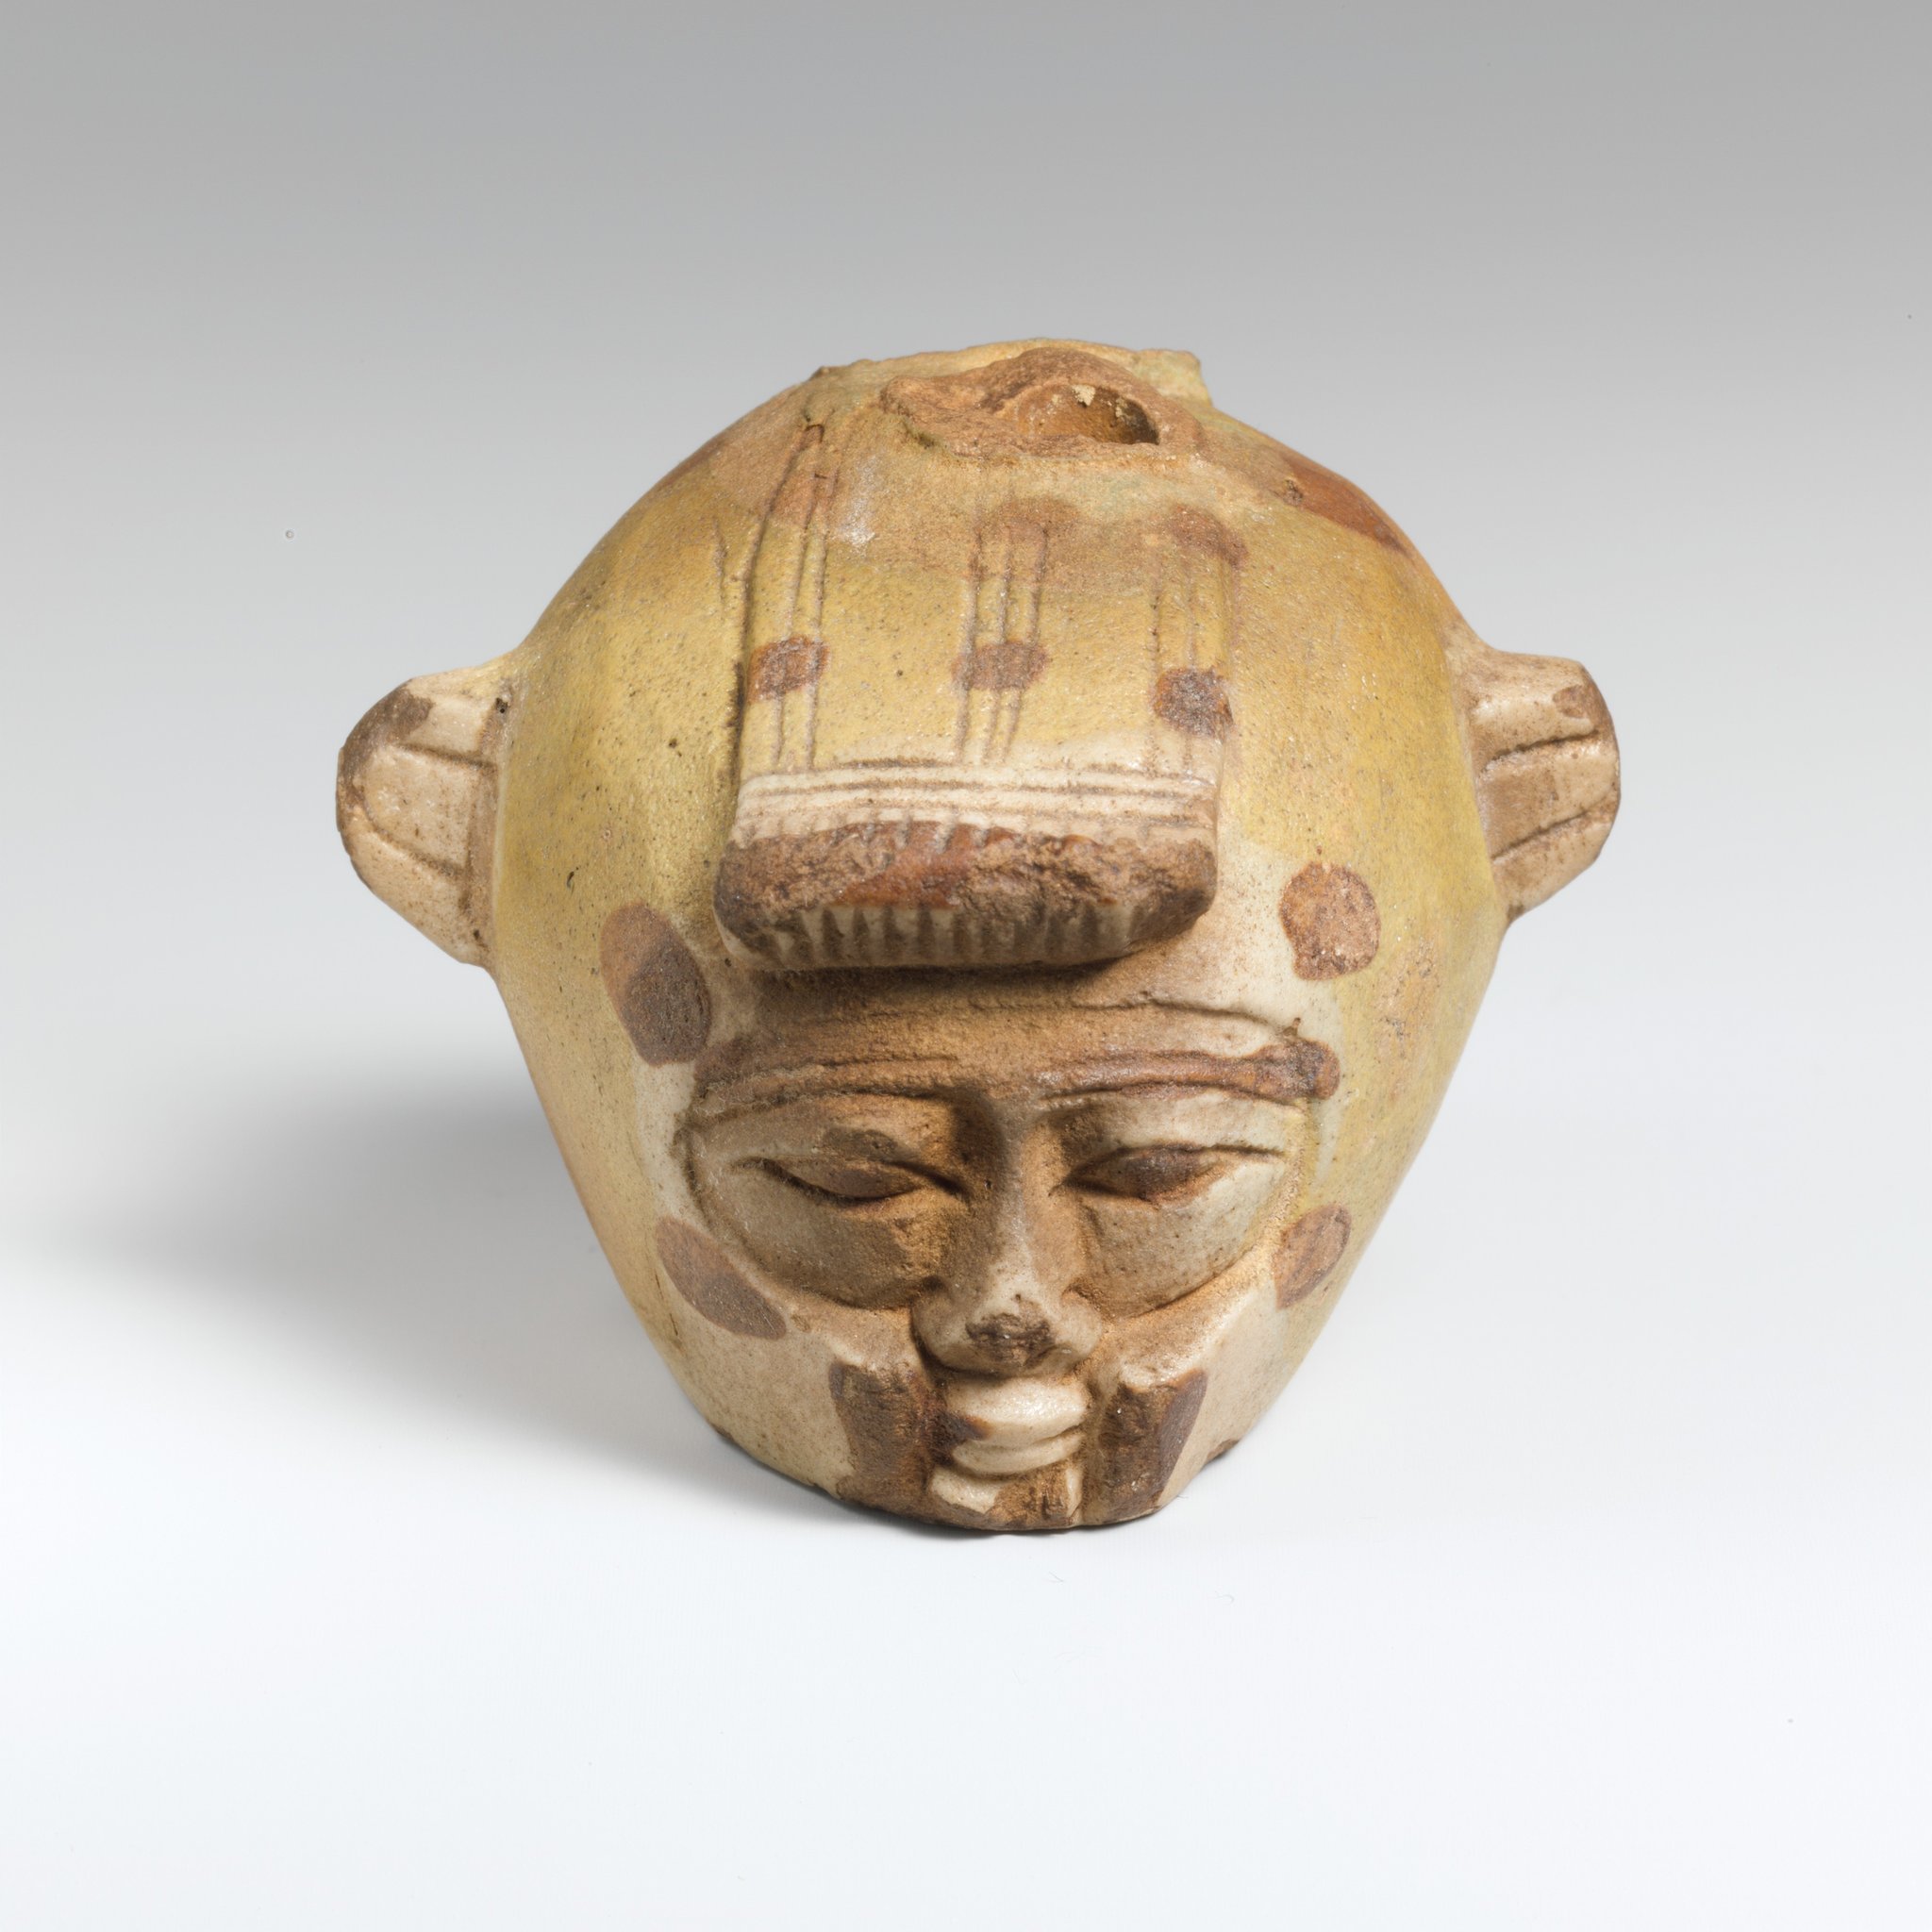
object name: aryballos in the form of a head wearing an animal skin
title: Faience aryballos (oil flask) in the form of a head wearing an animal skin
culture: east greek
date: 600-501 BCE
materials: faience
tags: heads